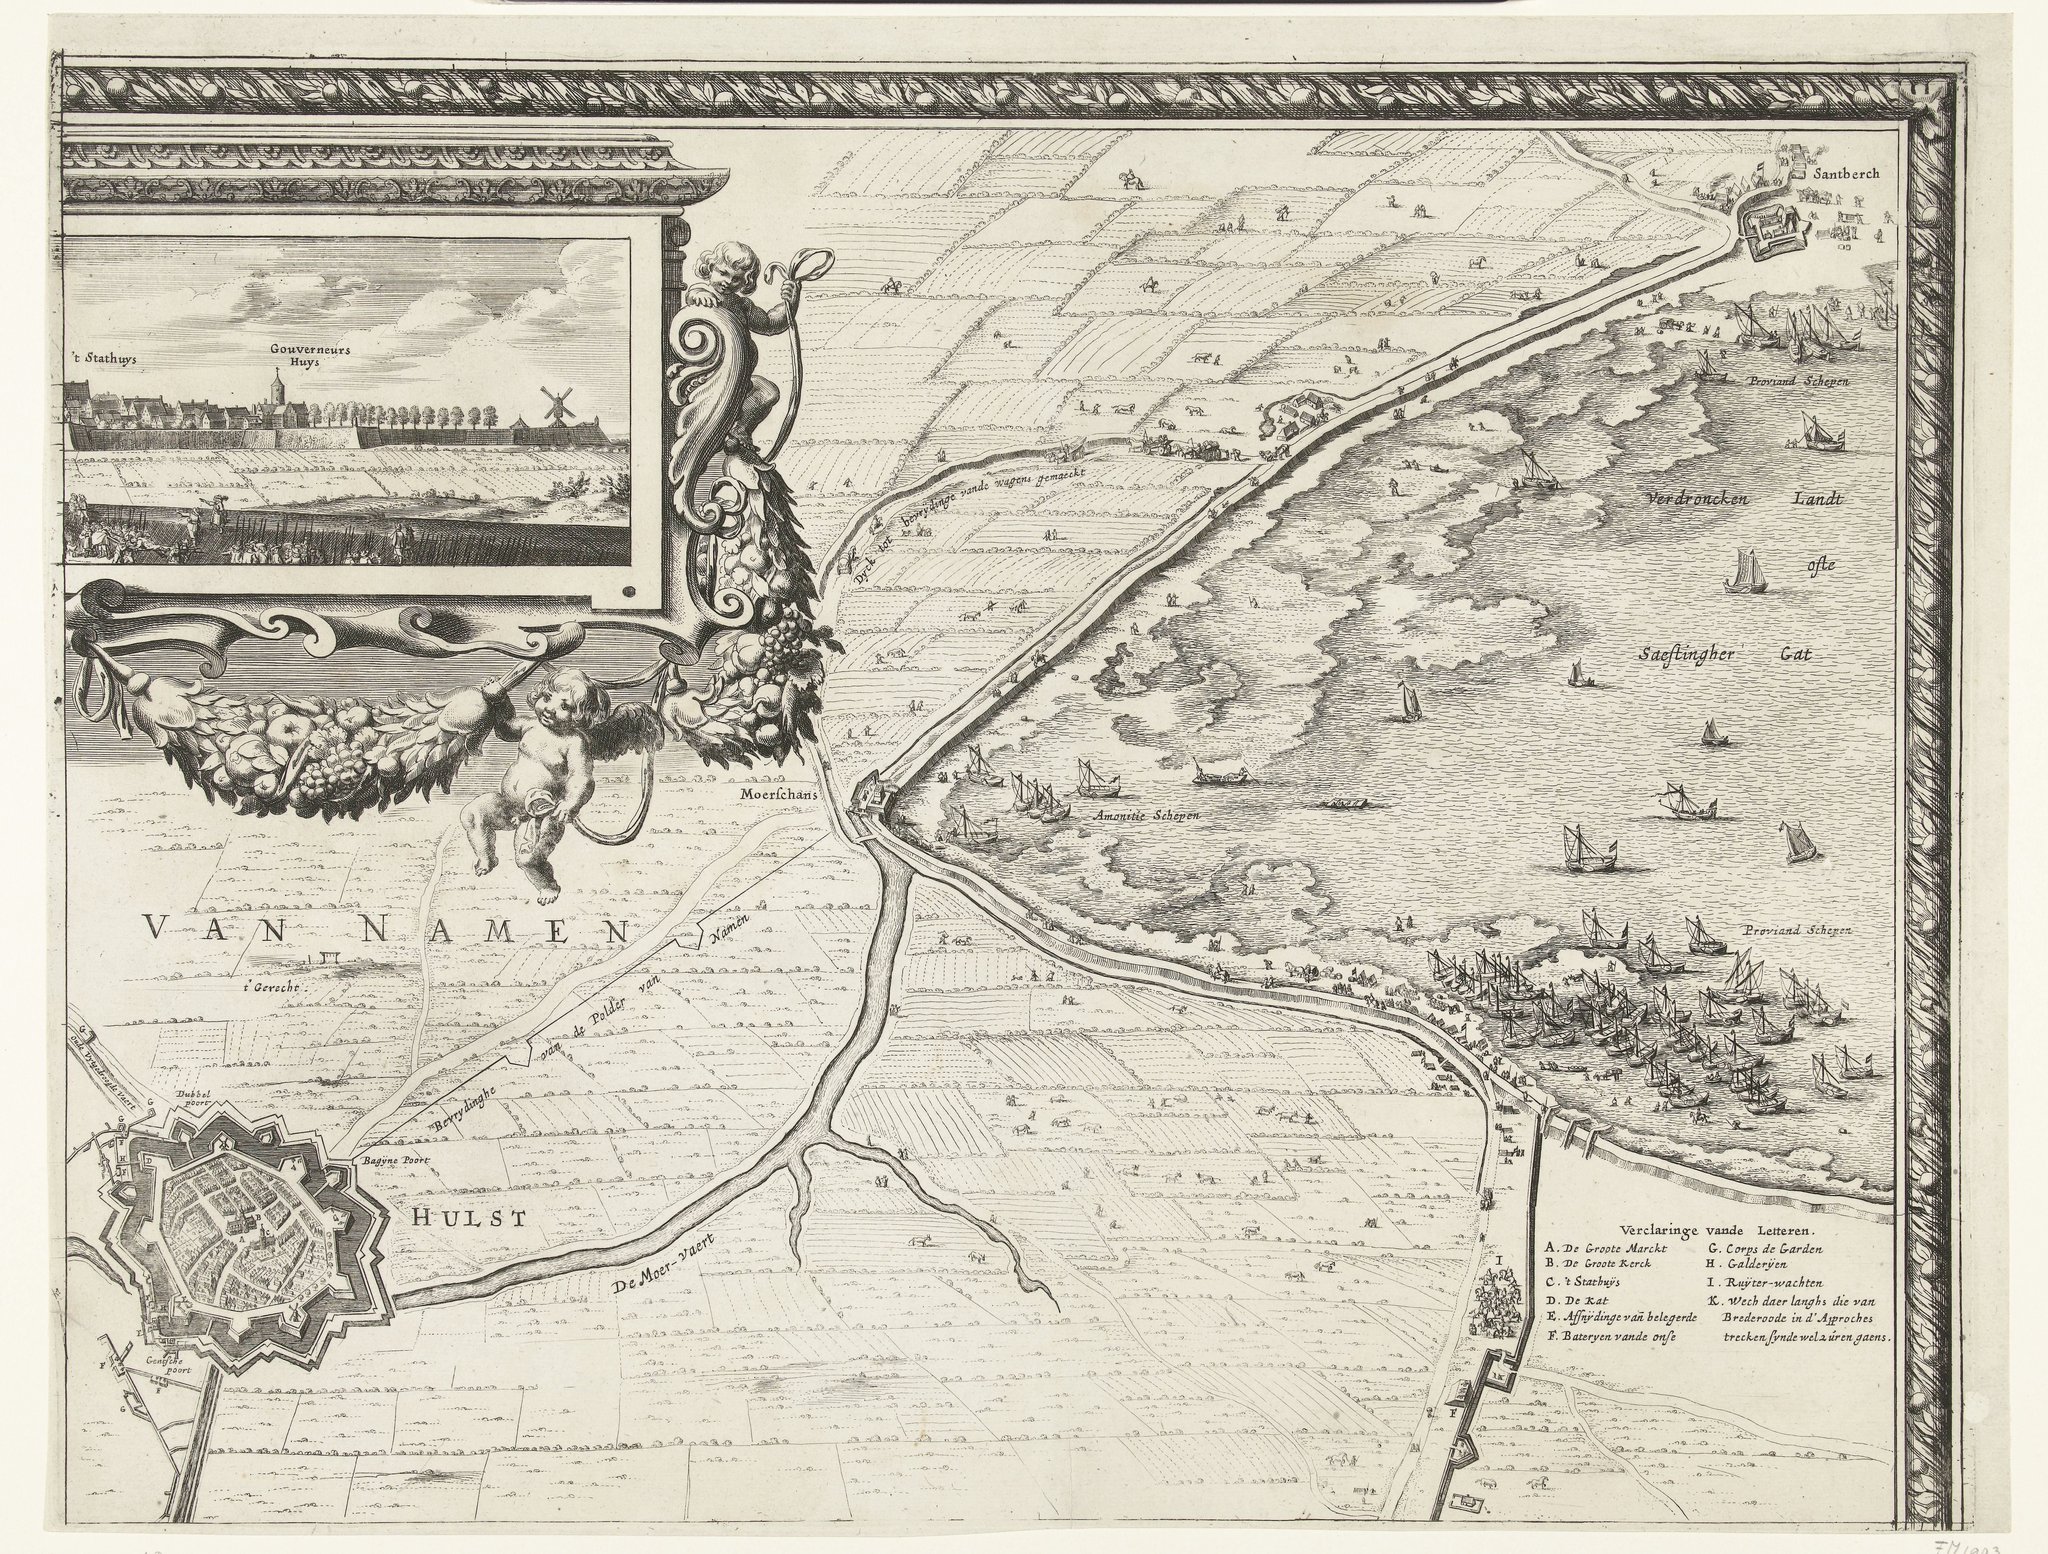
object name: print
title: Beleg en verovering van Hulst door Frederik Hendrik (blad rechtsboven), 1645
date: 1646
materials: paper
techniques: etching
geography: breda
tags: delft, frederick henry (prince of orange), fortress, maps of separate countries or regions, siege, position war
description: Beleg en verovering van Hulst door het Staatse leger onder Frederik Hendrik van 28 september tot 5 november 1645. Blad rechtsboven in de grote kaart. Links de stad Hulst, met de rechterhelft van een profiel van de stad. Rechts proviandschepen op het Verdronken Land van Saeftinghe en de legenda A-K. Onderdeel van een ongemonteerd ensemble bestaande uit de grote kaart van het beleg in 4 bladen, een tekstblad in het Frans (het tekstblad in het Nederlands ontbreekt) en de uittocht van het Spaanse garnizoen in 2 bladen.